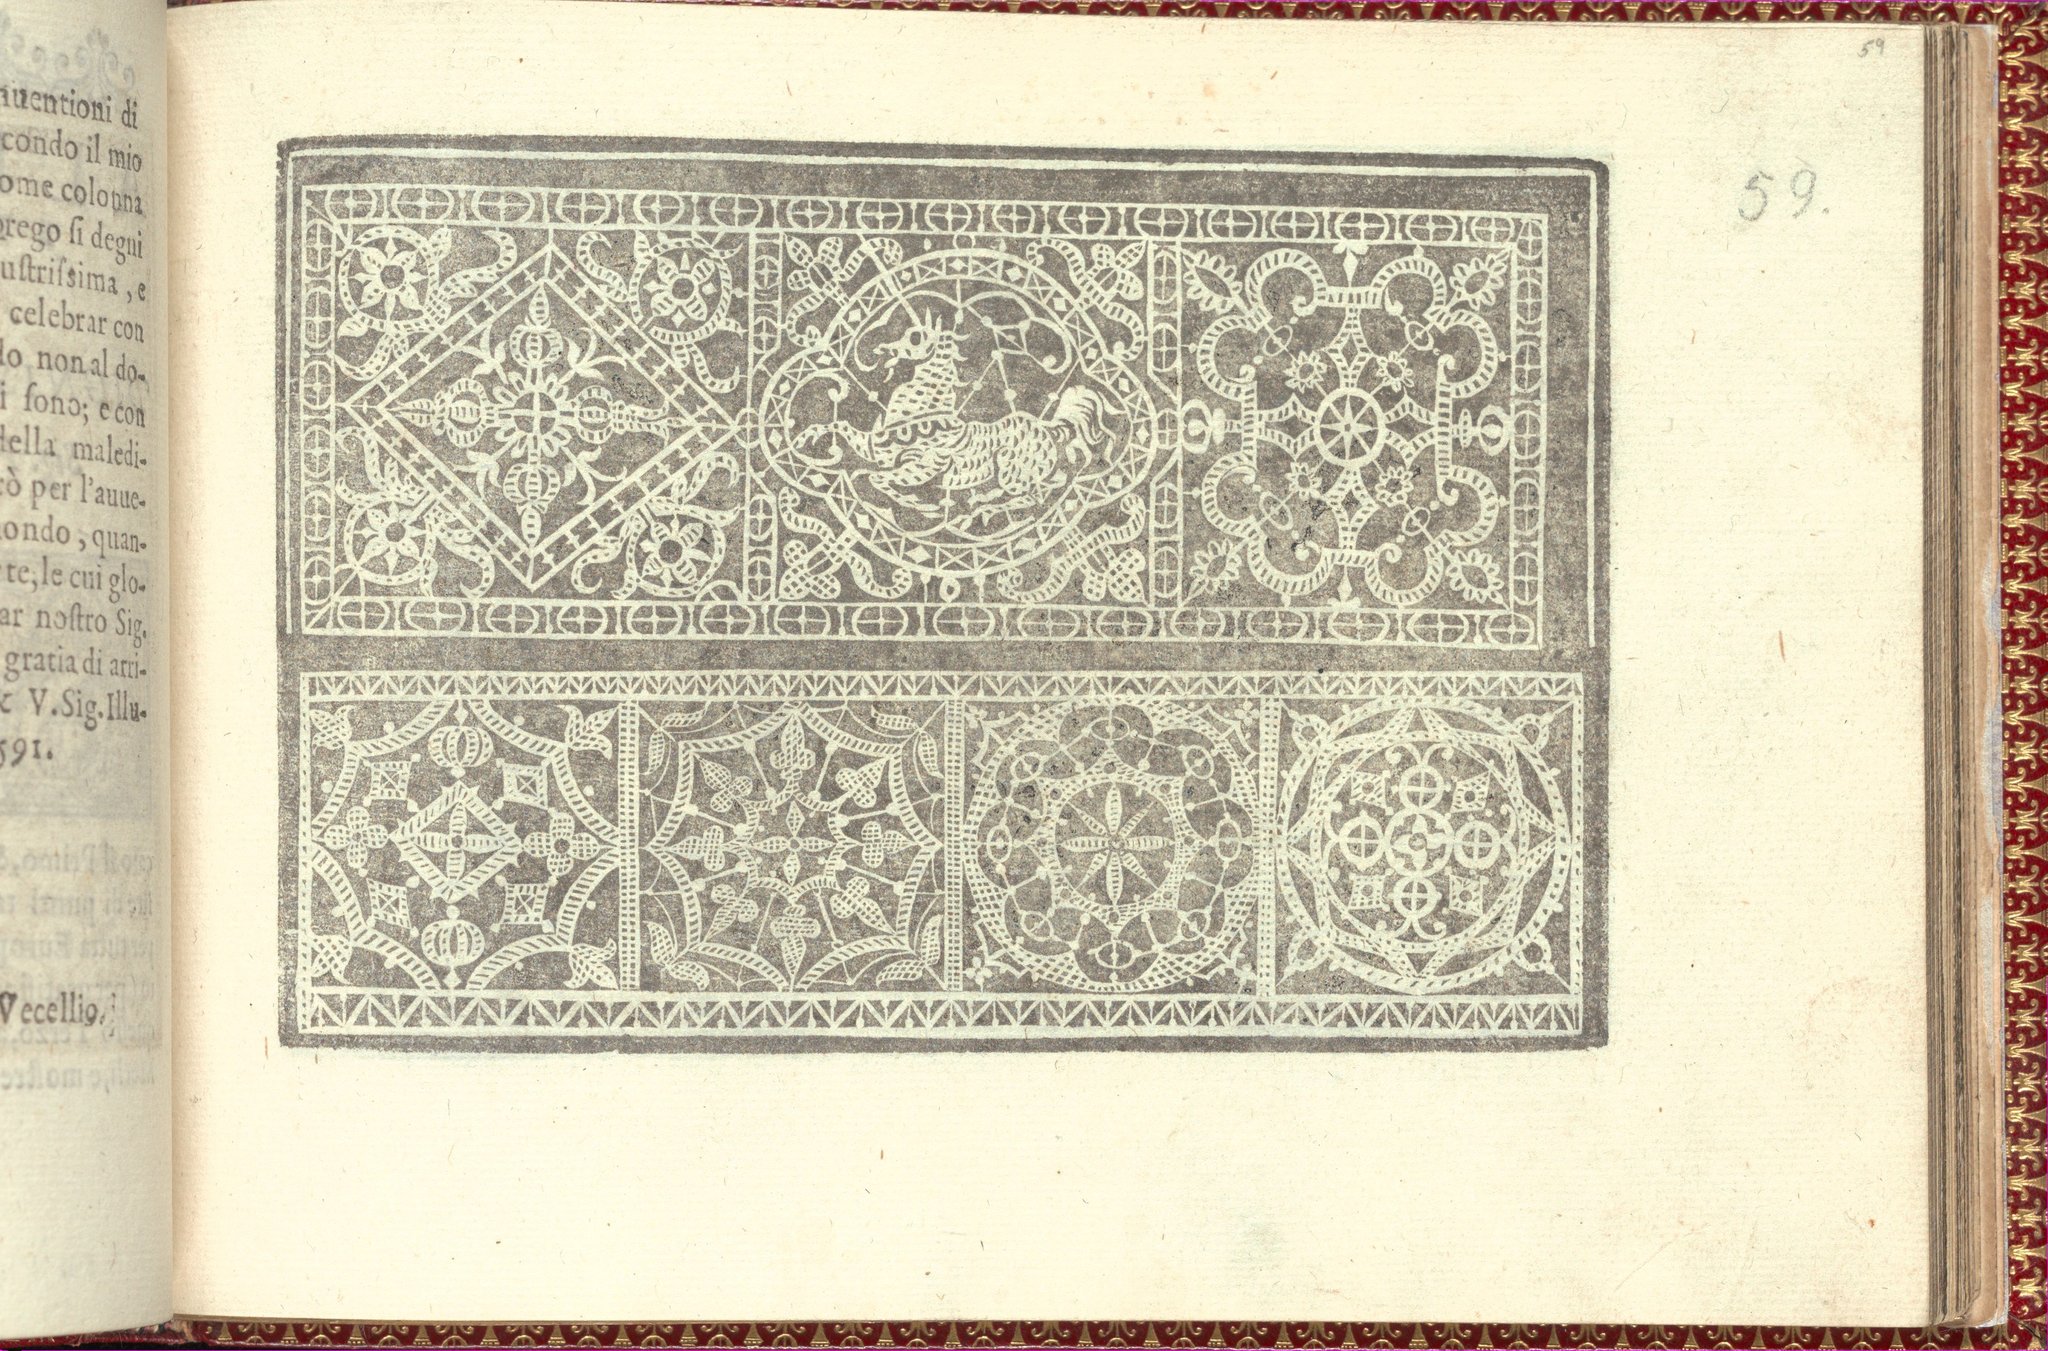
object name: book print ornament architecture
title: Corona delle Nobili et Virtuose Donne: Libro I-IV, page 59 (recto)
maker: cesare vecellio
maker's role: publisher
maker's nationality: italian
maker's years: 1521-1601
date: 1601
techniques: woodcut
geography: italy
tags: ornament,unicorns